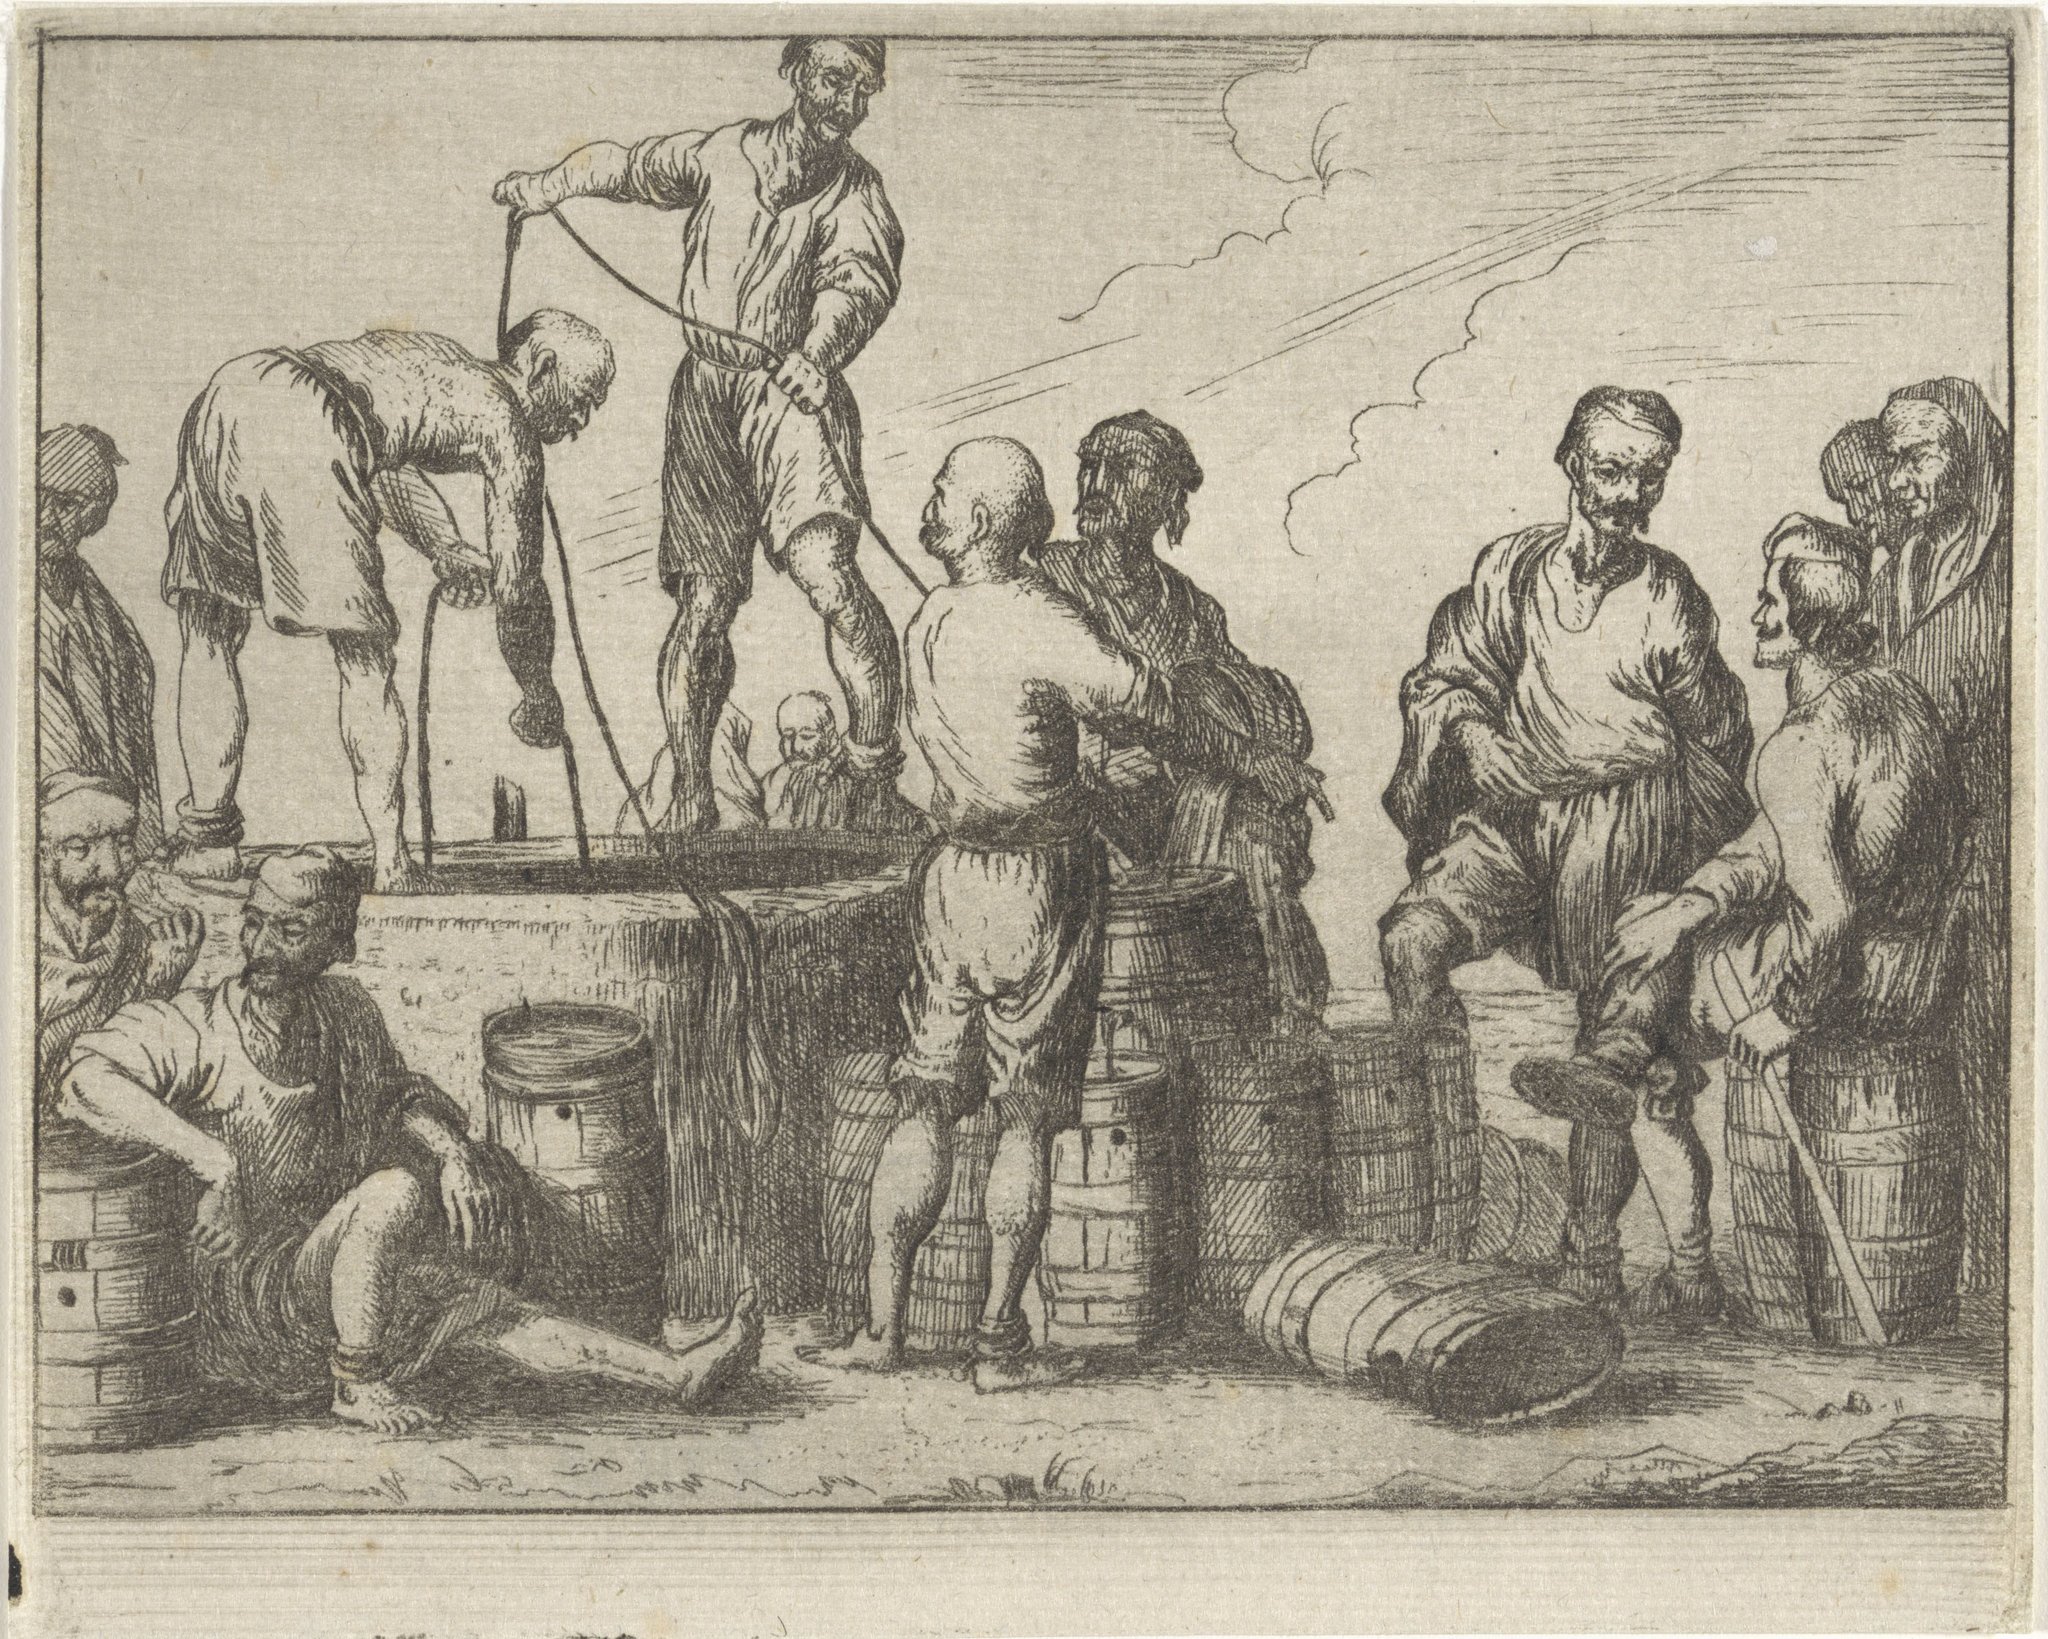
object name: print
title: Haventaferelen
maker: m. schaep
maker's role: print maker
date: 1649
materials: paper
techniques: etching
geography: northern netherlands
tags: harbour, well, wooden container: barrel, cask, bucket, slavery; serfs and enslaved persons, seaman: sailor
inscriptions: collector's mark: Lugt 2228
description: Islamitische galeislaven rond een put. Ze hijsen water uit de put en gieten het in tonnen. Deze tot slaaf gemaakte mannen zijn als moslims te herkennen door het typerende kapsel (hoofd op een pluk na kaalgeschoren) dat zij verplicht waren te hebben. Rechts zit een opzichter.